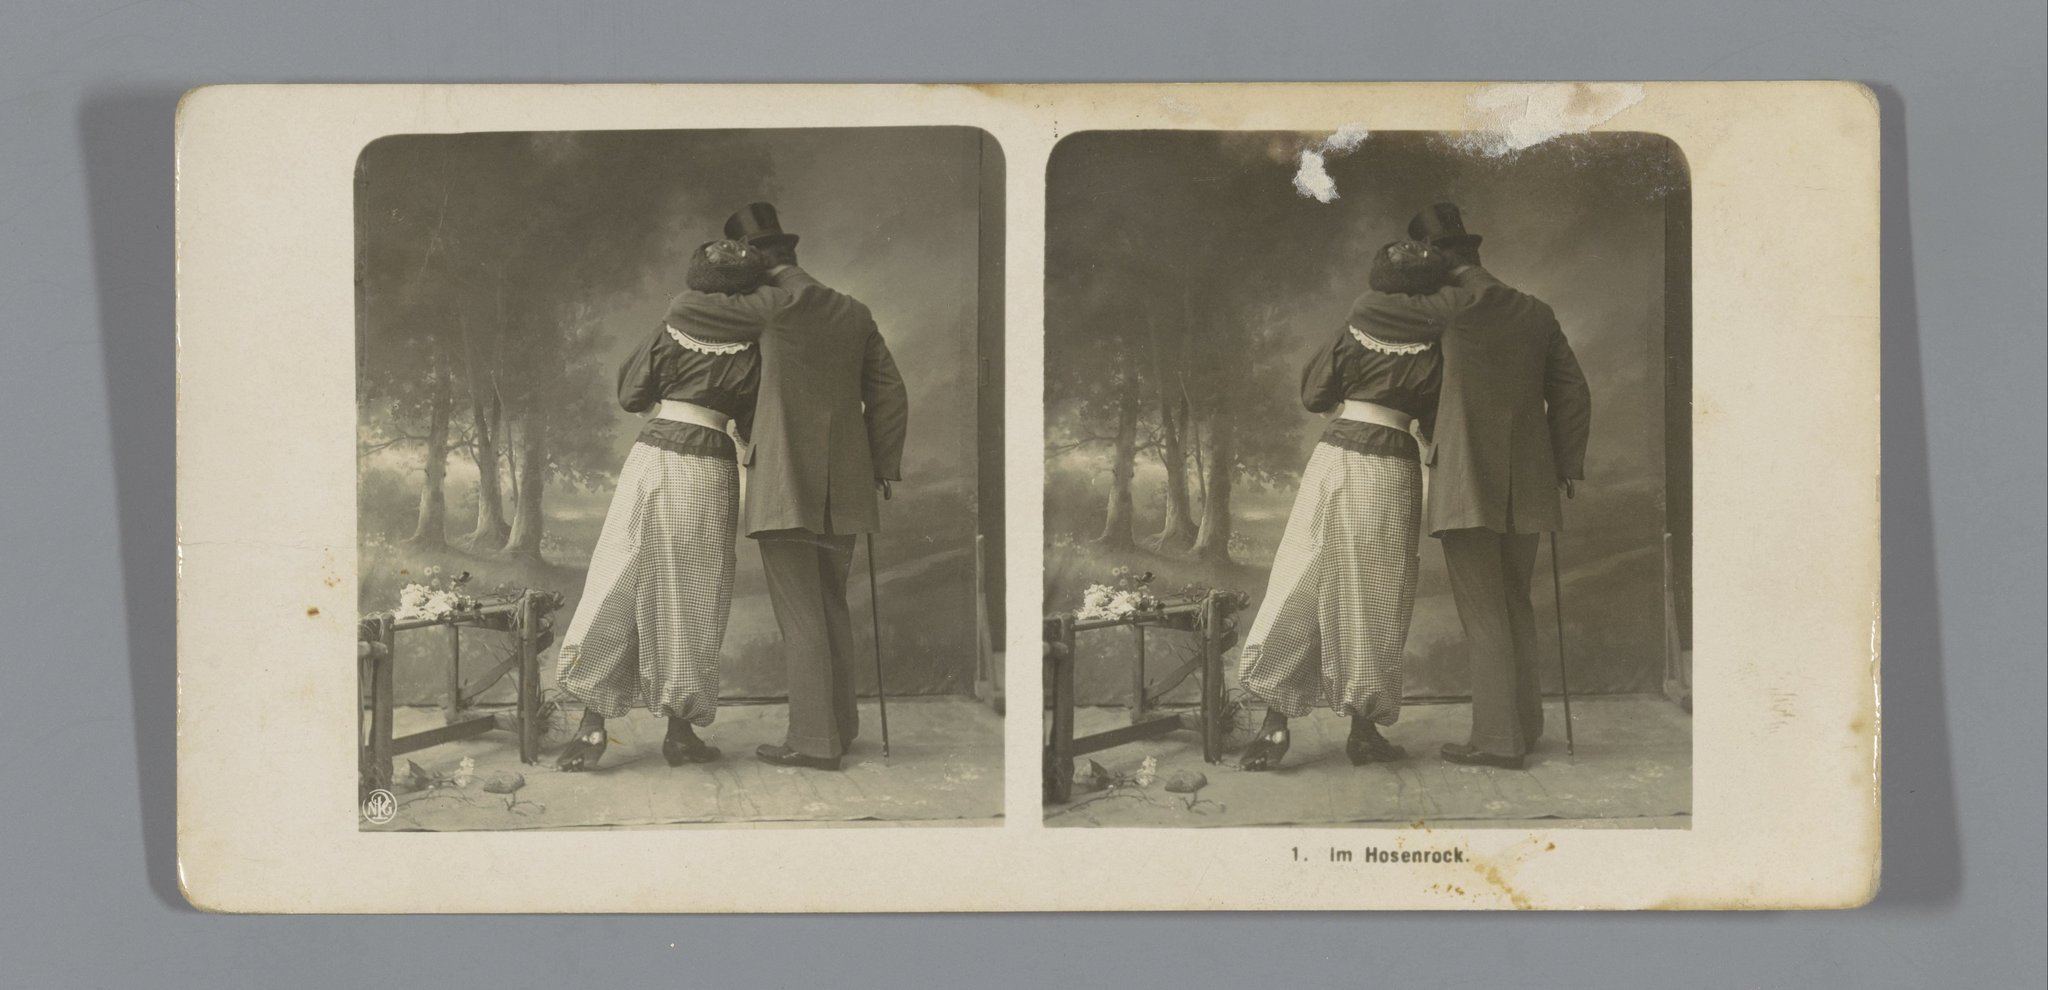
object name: stereograph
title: 1. Im Hosenrock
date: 1905-1920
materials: cardboard, photographic support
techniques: gelatin silver print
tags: trousers, breeches (+ women's clothes), couple of lovers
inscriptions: monogram: ‘NPG’